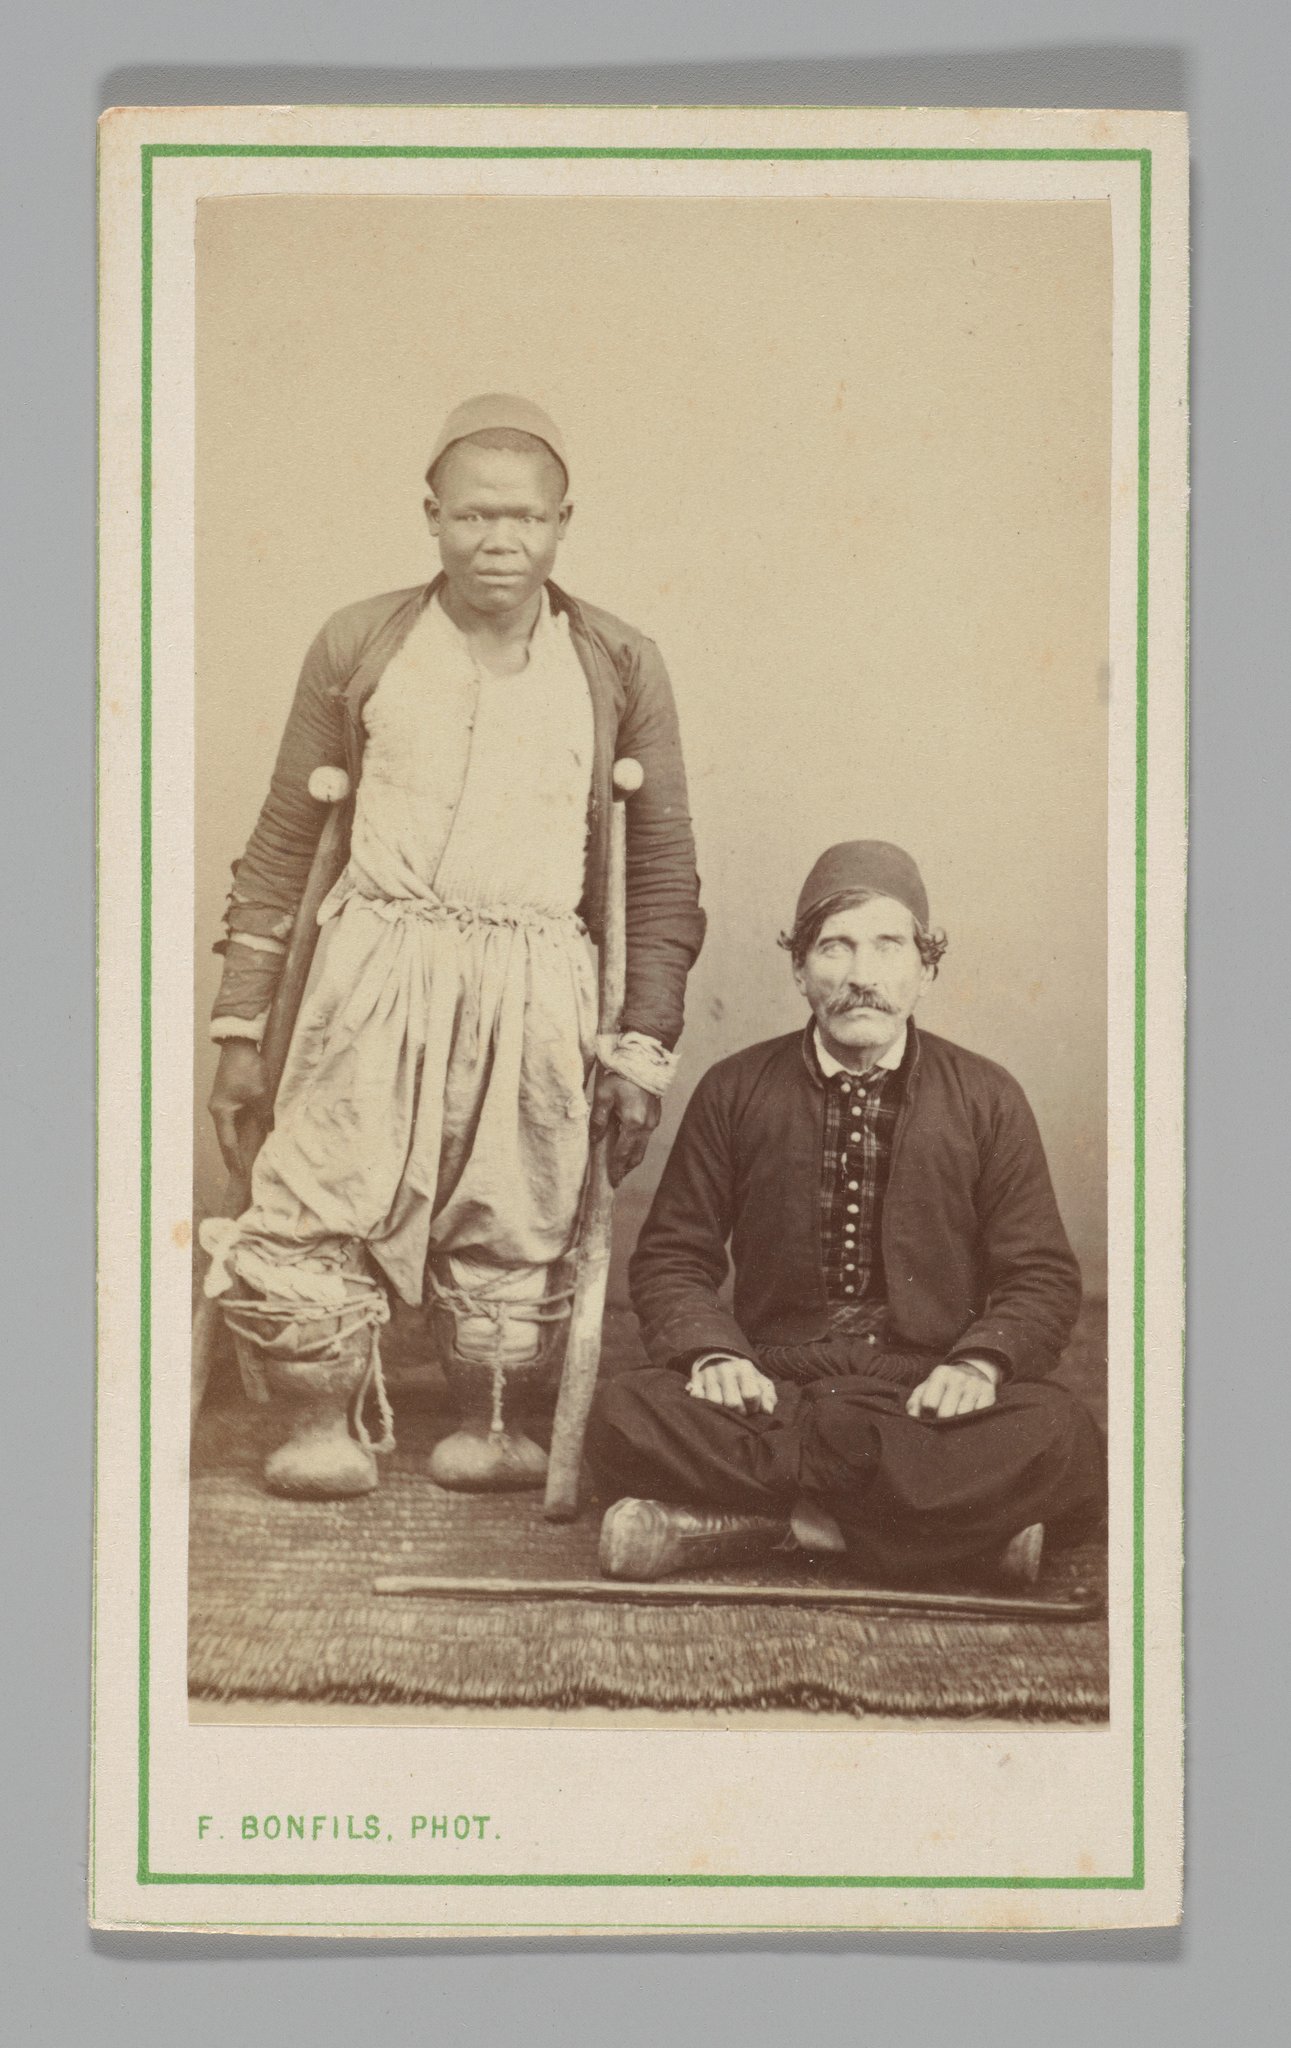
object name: carte de visite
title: [Studio Portrait: Mahomedan Cripples, Beirut, Syria]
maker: félix bonfils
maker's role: fotograaf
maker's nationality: french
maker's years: 1831-1885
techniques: albumen silver print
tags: men,portraits